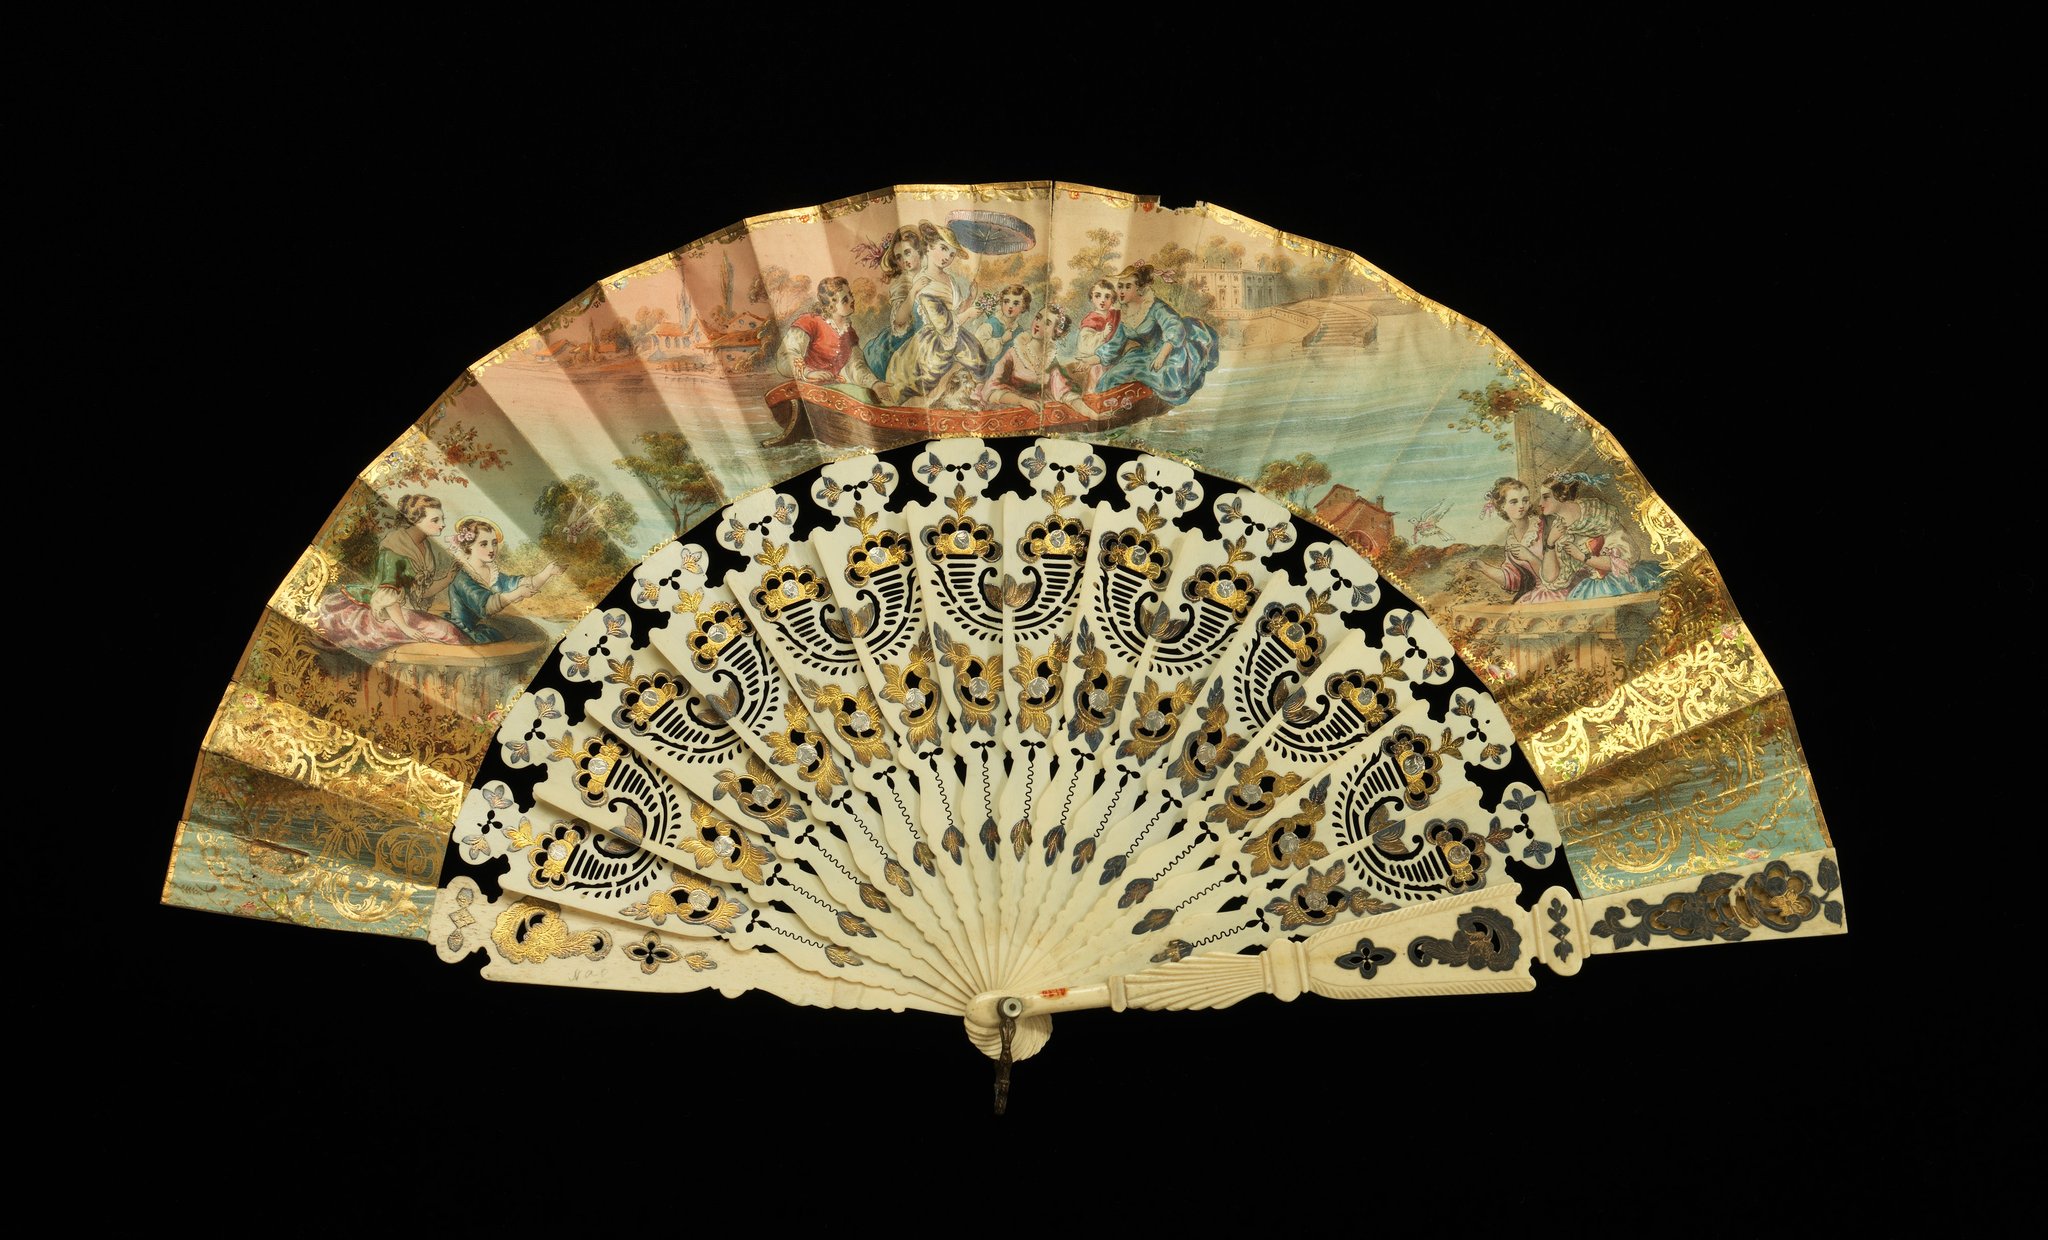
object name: fan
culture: french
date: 1860-1870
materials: gouache, ivory, metal, mother of pearl, paper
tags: women,dogs,boats